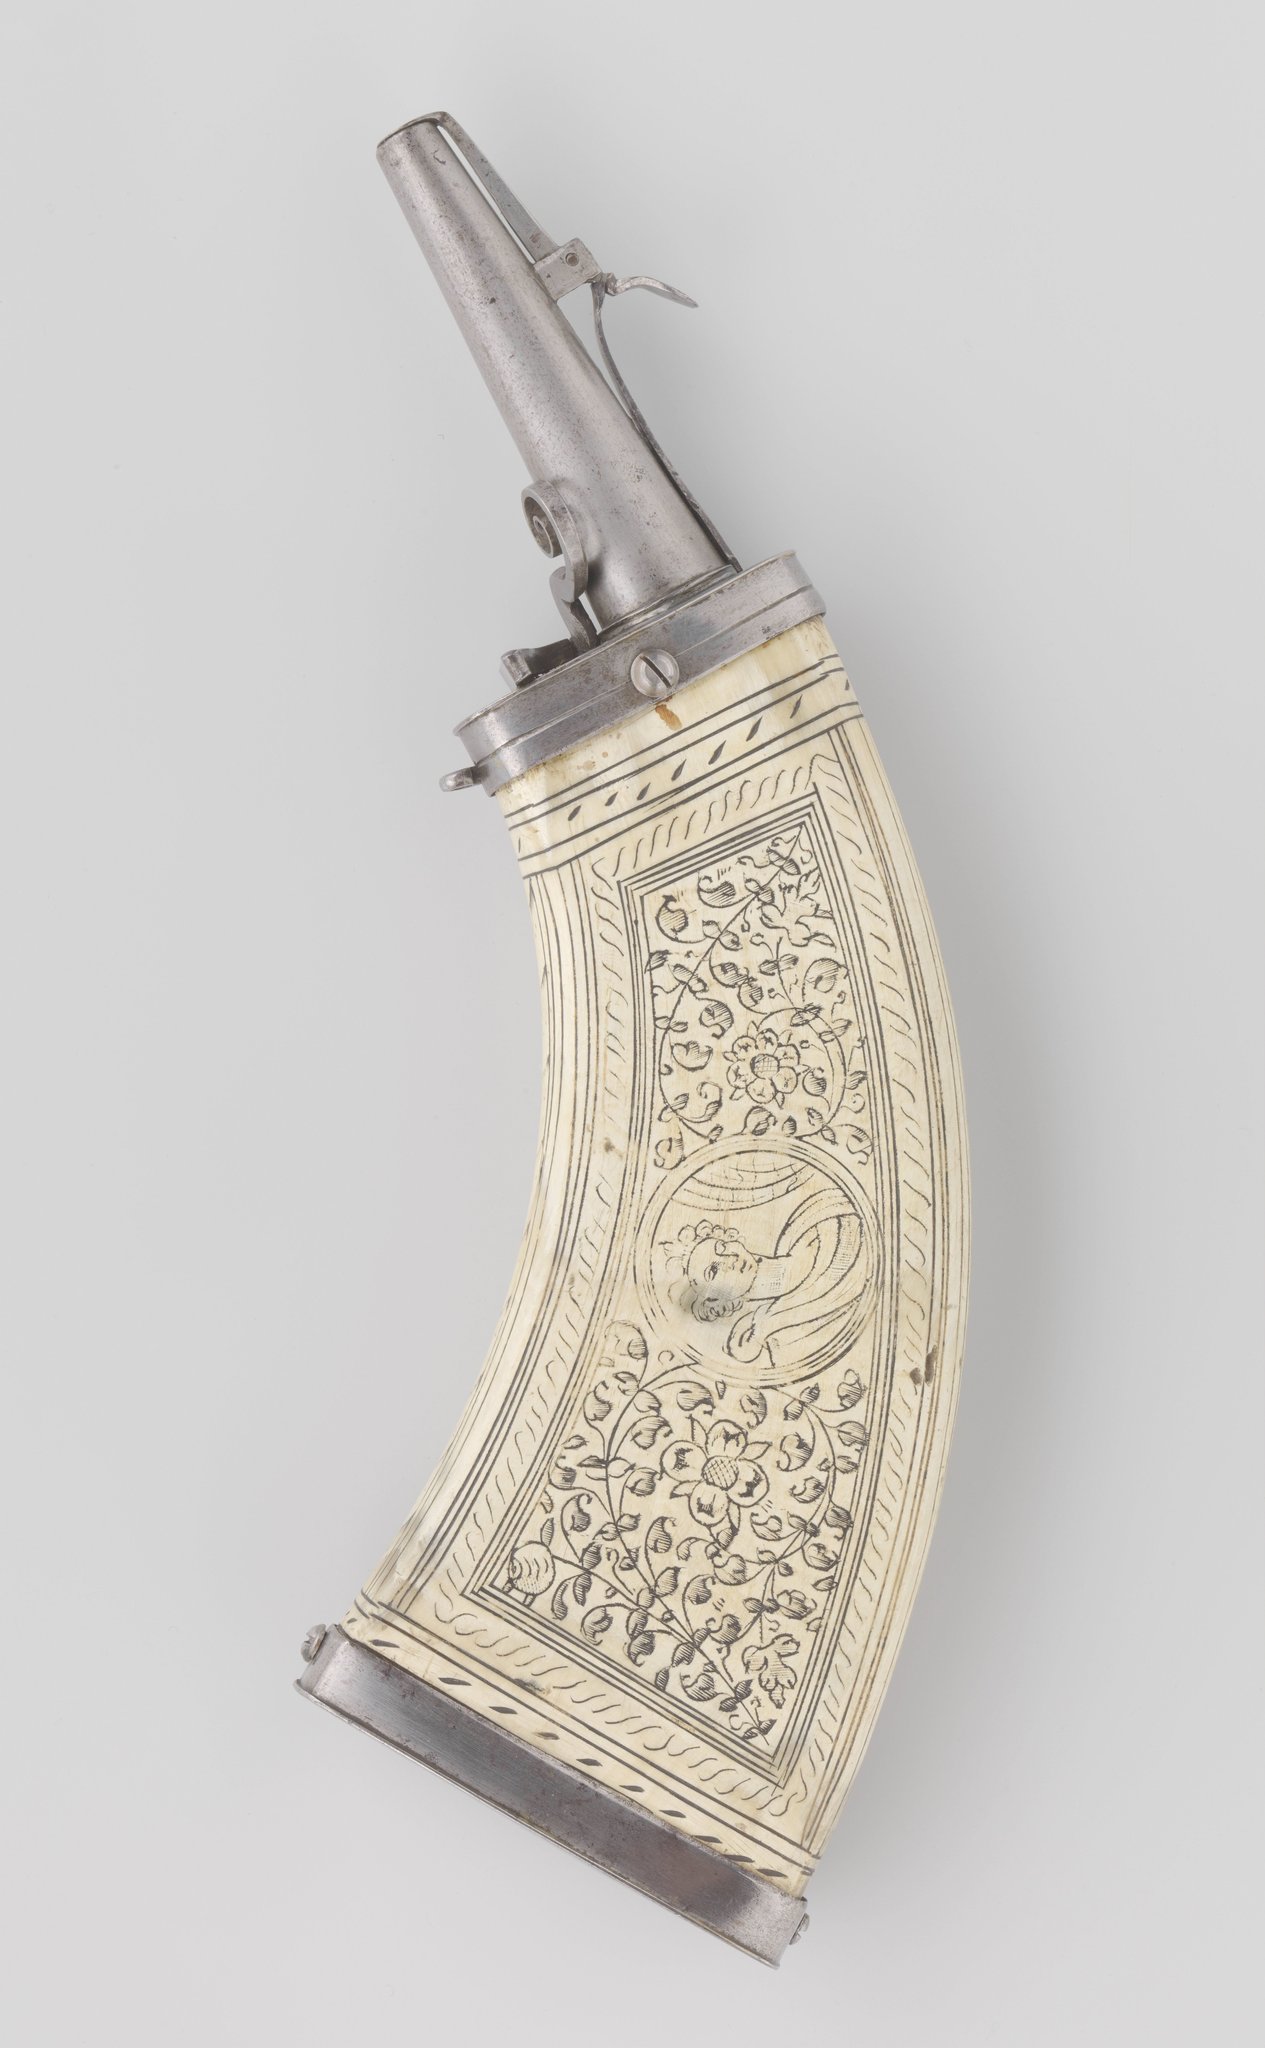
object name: powder horn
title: Platte gebogen kruithoorn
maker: Anonymous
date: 1600-1625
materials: horn, iron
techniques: engraving, forging, pressing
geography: netherlands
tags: ornament derived from plant forms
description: Powder flask of cow's horn, made in the Netherlands, first quarter 17th century.